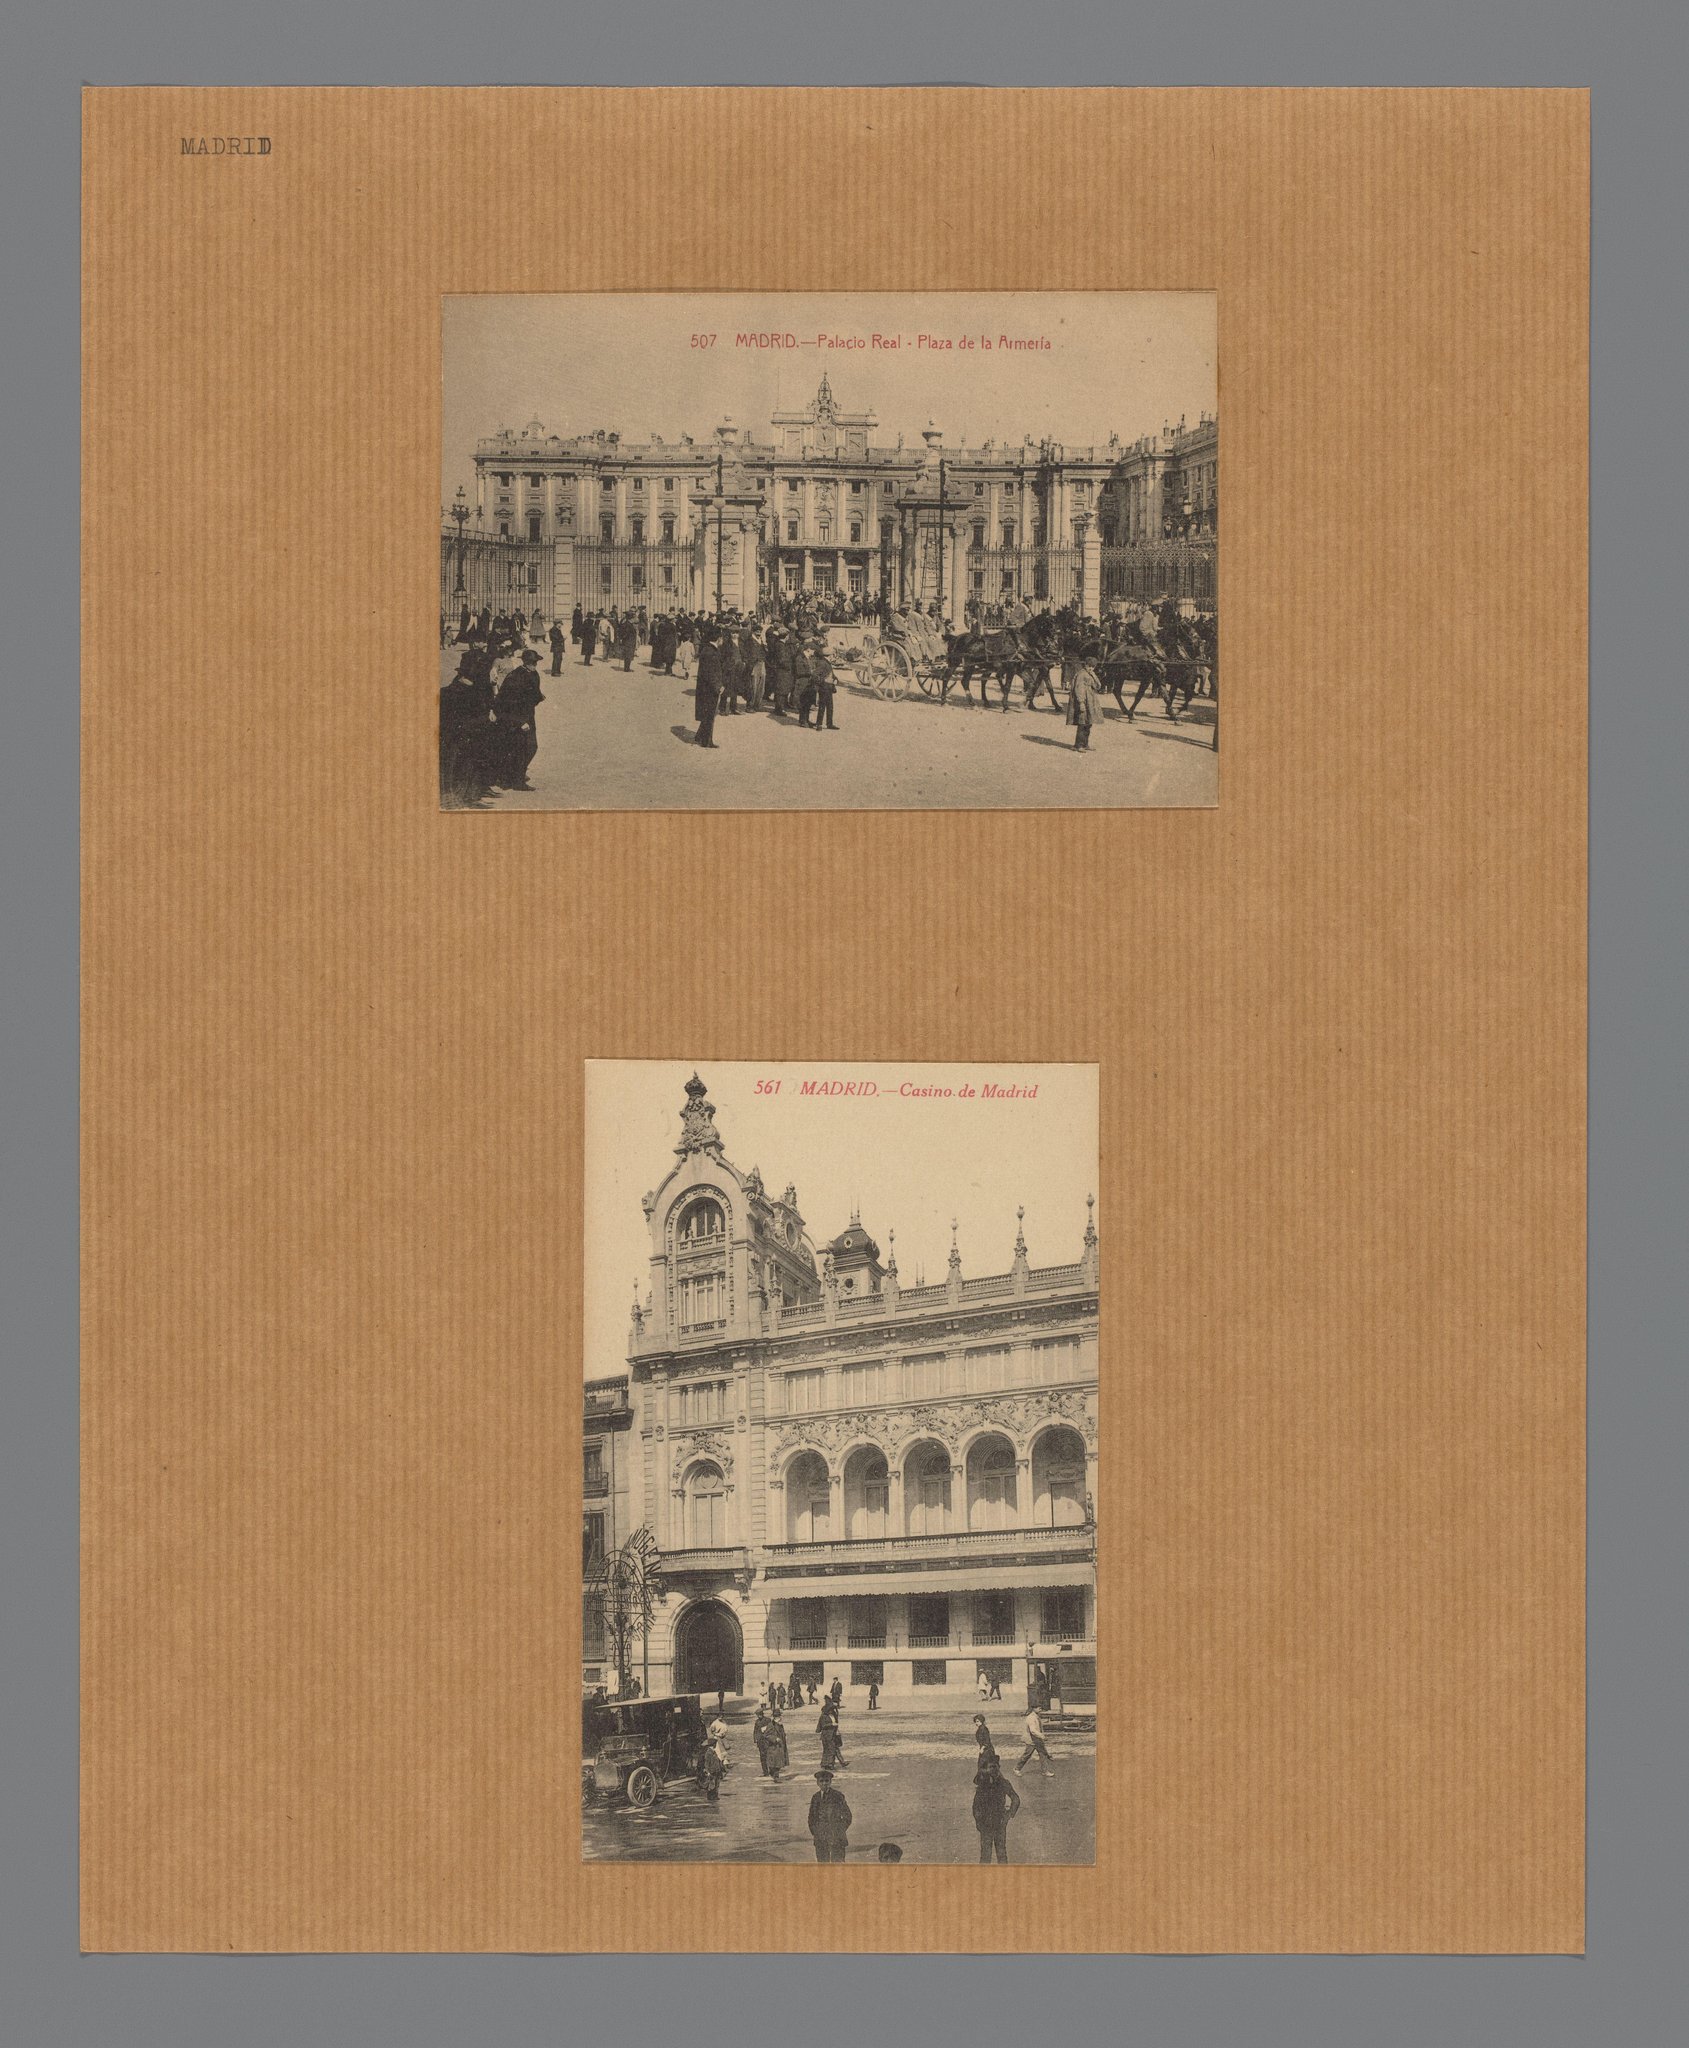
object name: photograph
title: Madrid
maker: Anonymous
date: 1860-1930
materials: paper, photographic support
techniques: photograph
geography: spain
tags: madrid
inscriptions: stamp: ‘UNIVERSITEIT VAN AMSTERDAM / KUNST / HISTORISCH / INSTITUUT’, inscription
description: Vel met twee ansichtkaarten uit de studiecollectie van het Kunsthistorisch Instituut van de Universiteit van Amsterdam.